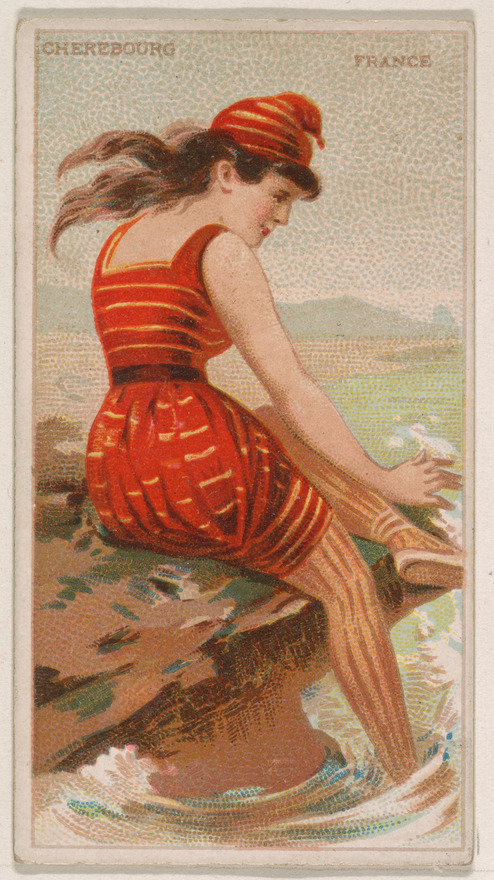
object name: print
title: Cherebourg, France, from the Surf Beauties series (N232), issued by Kinney Bros.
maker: kinney brothers tobacco company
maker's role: publisher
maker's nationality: american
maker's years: 1869-2011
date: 1889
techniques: color lithograph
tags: profiles,women